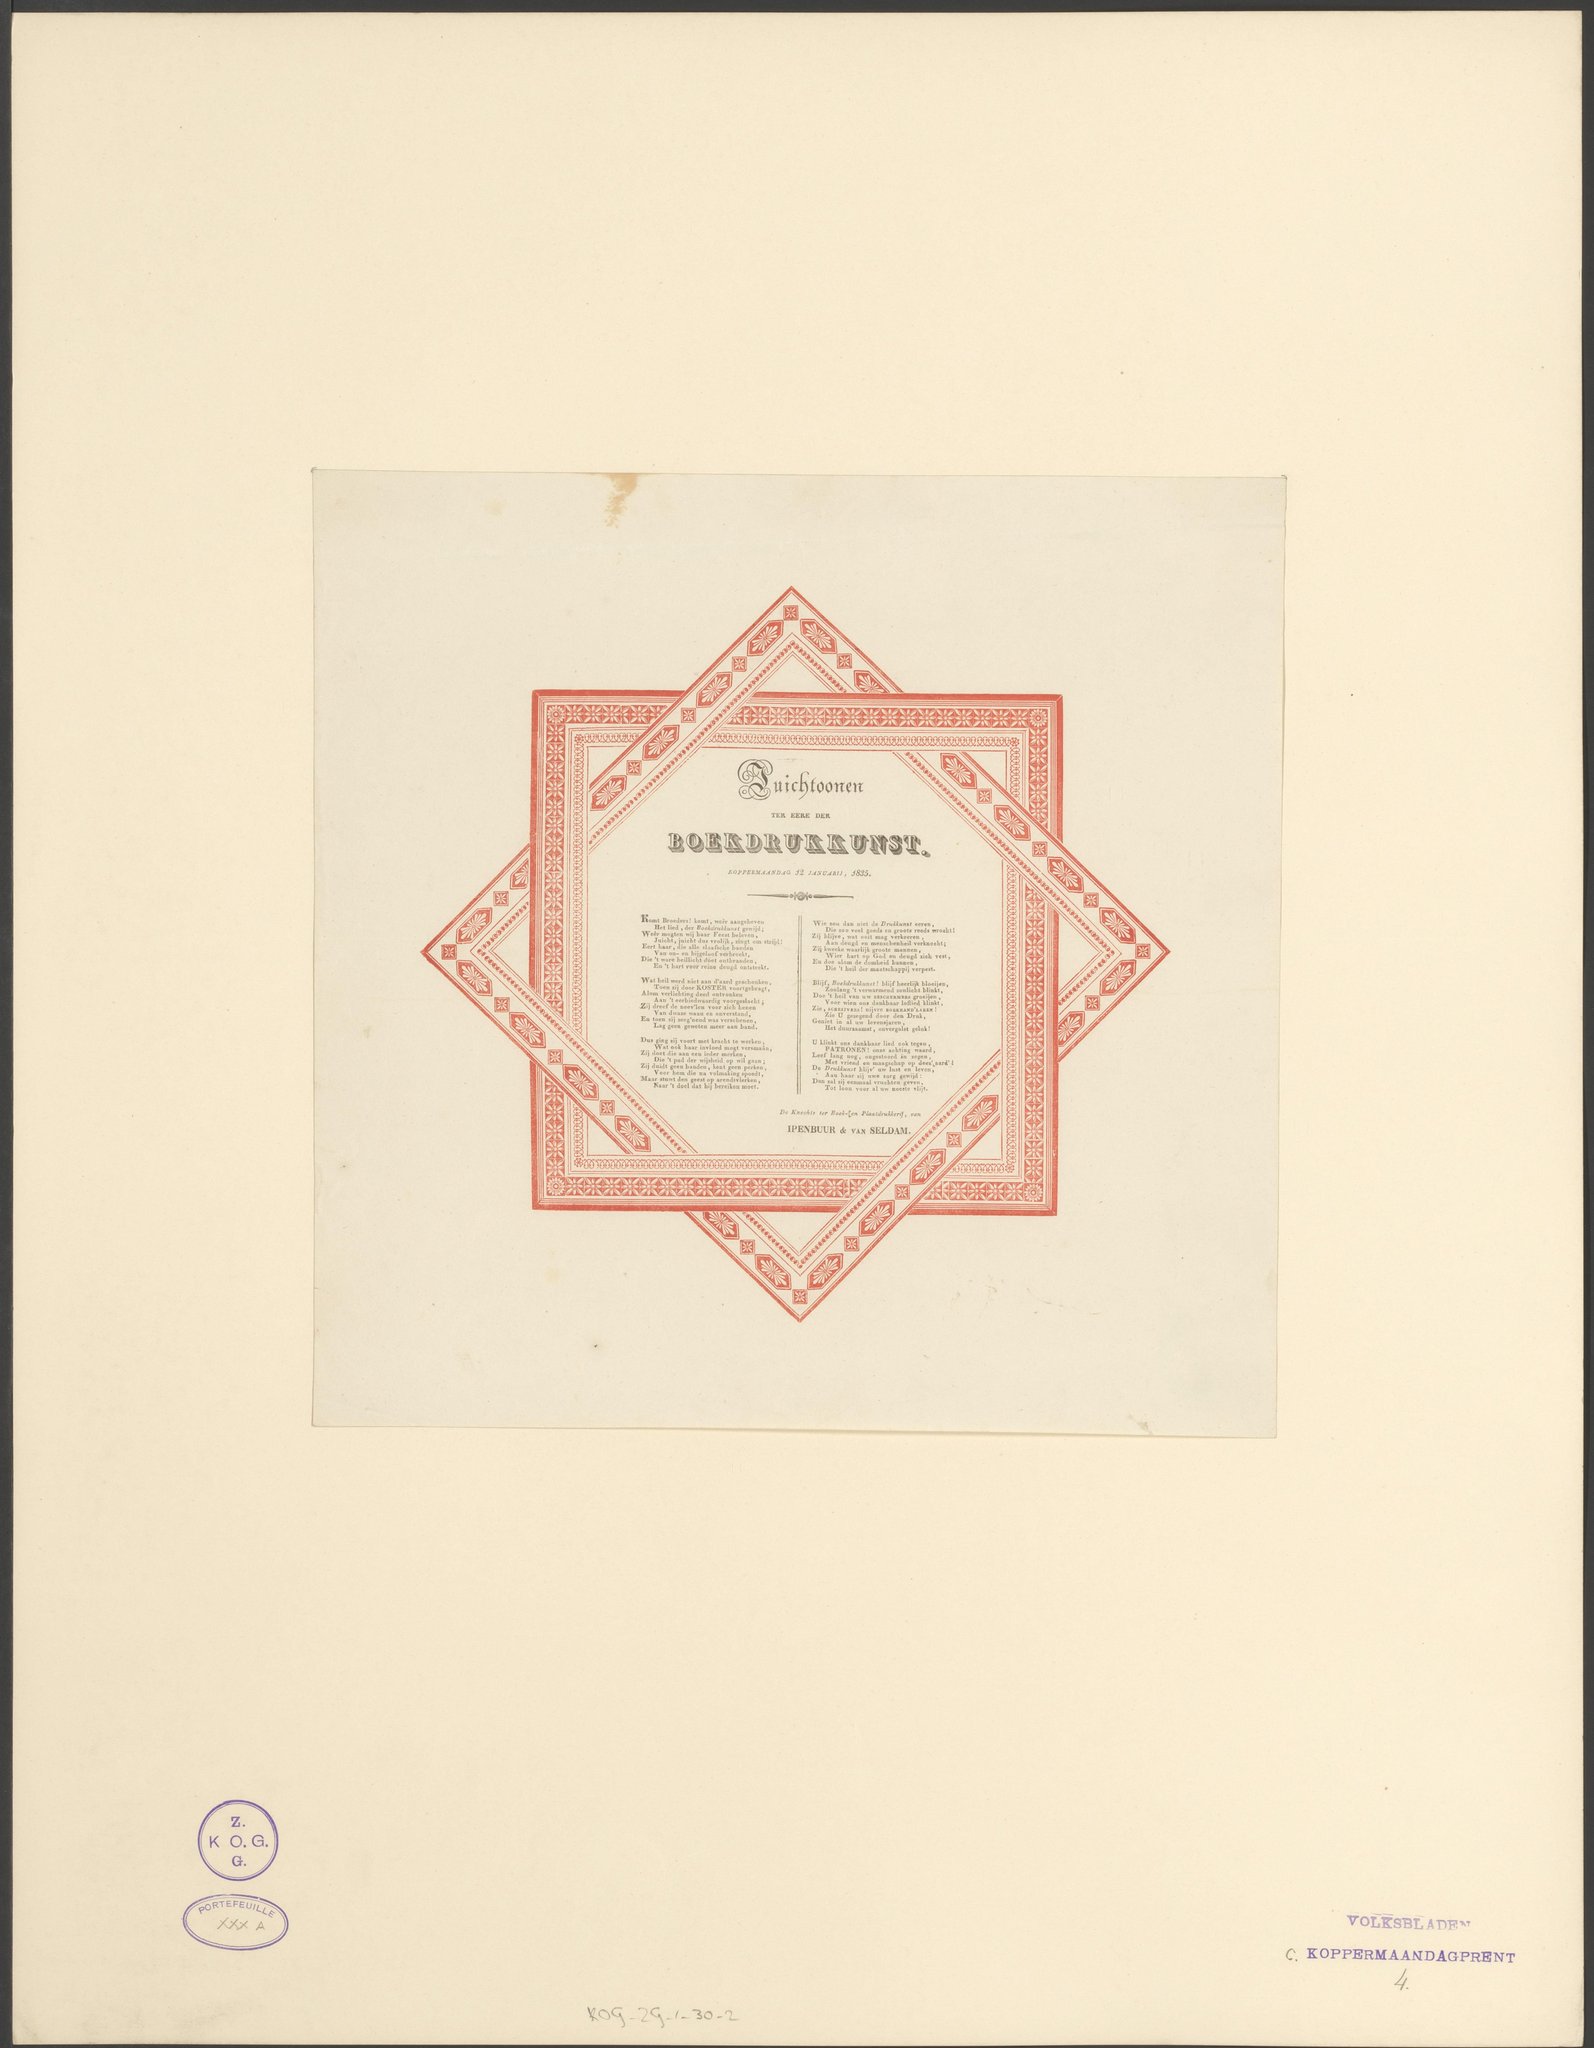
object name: text sheet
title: Juichtoonen ter eere der boekdrukkunst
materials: paper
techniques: letterpress printing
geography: amsterdam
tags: printing press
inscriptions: stamp, collector's mark: Lugt 1641, stamp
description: Koppermaandagprent met lofzang op de boekdrukkunst, voor koppermaandag 12 januari 1835. Met een vers in twee kolommen. Onderwerpsrubrieken binnen de Atlas Zeden en Gewoonten: Zeden en Gewoonten in engeren zin. Volksleven. Volksbladen. Koppermaandagwenschen.